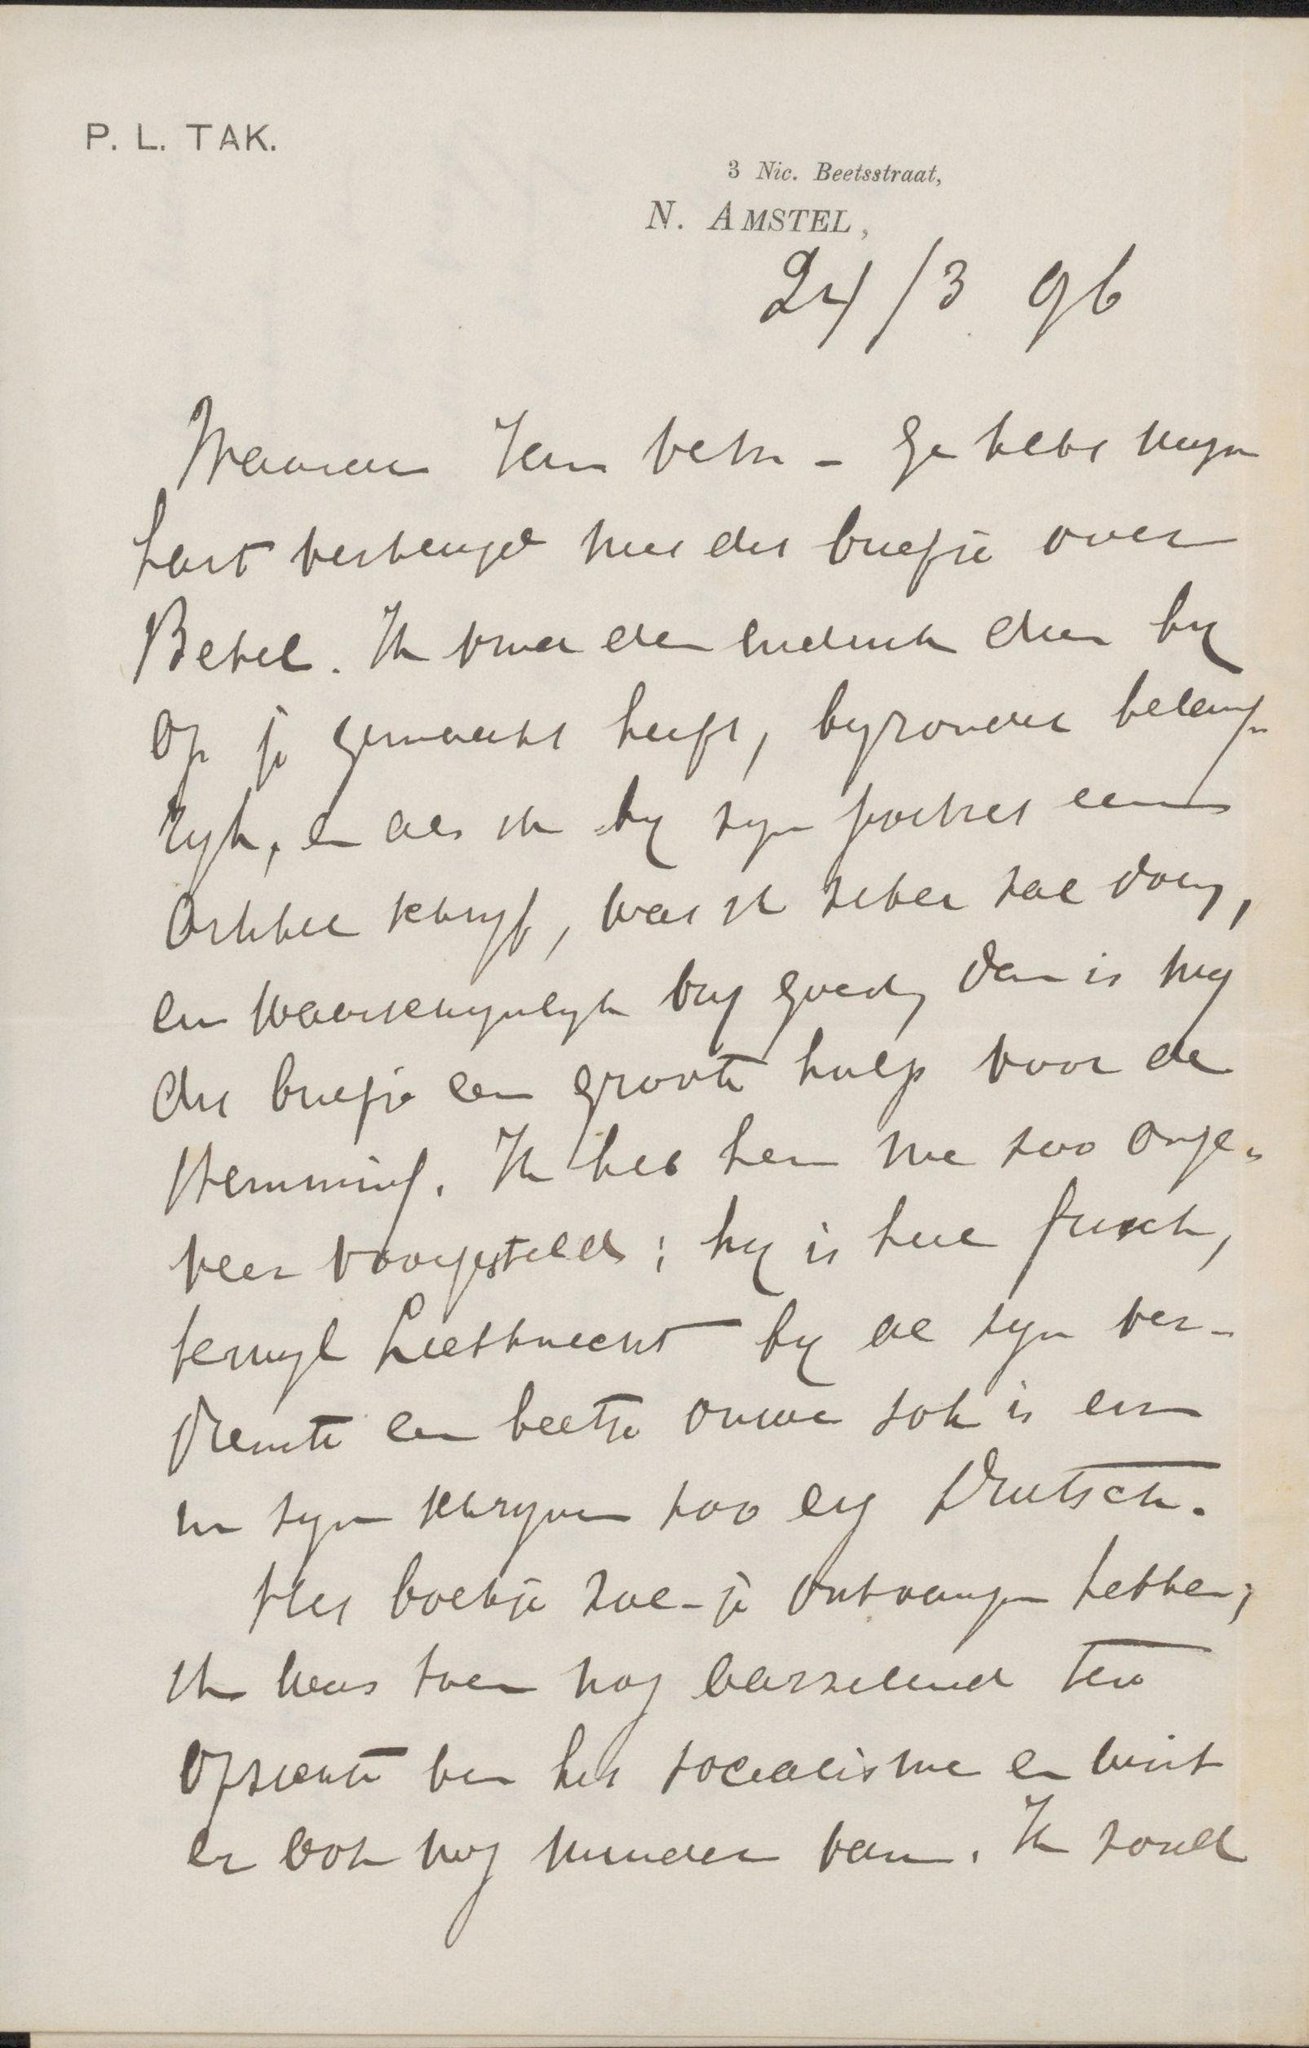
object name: letter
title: Brief aan Jan Veth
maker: pieter lodewijk tak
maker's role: politician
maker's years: 1848-1907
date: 1896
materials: ink, paper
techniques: pen, printing, writing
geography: nieuwer-amstel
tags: dordrecht, amsterdam, painter, print maker, draughtsman, designer, jan veth, official, klaas groesbeek, haarlem, publisher, hermanus diedericus tjeenk willink (1843-1917), anonymous historical person portrayed, london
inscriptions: collector's mark: ‘RPK’, watermark